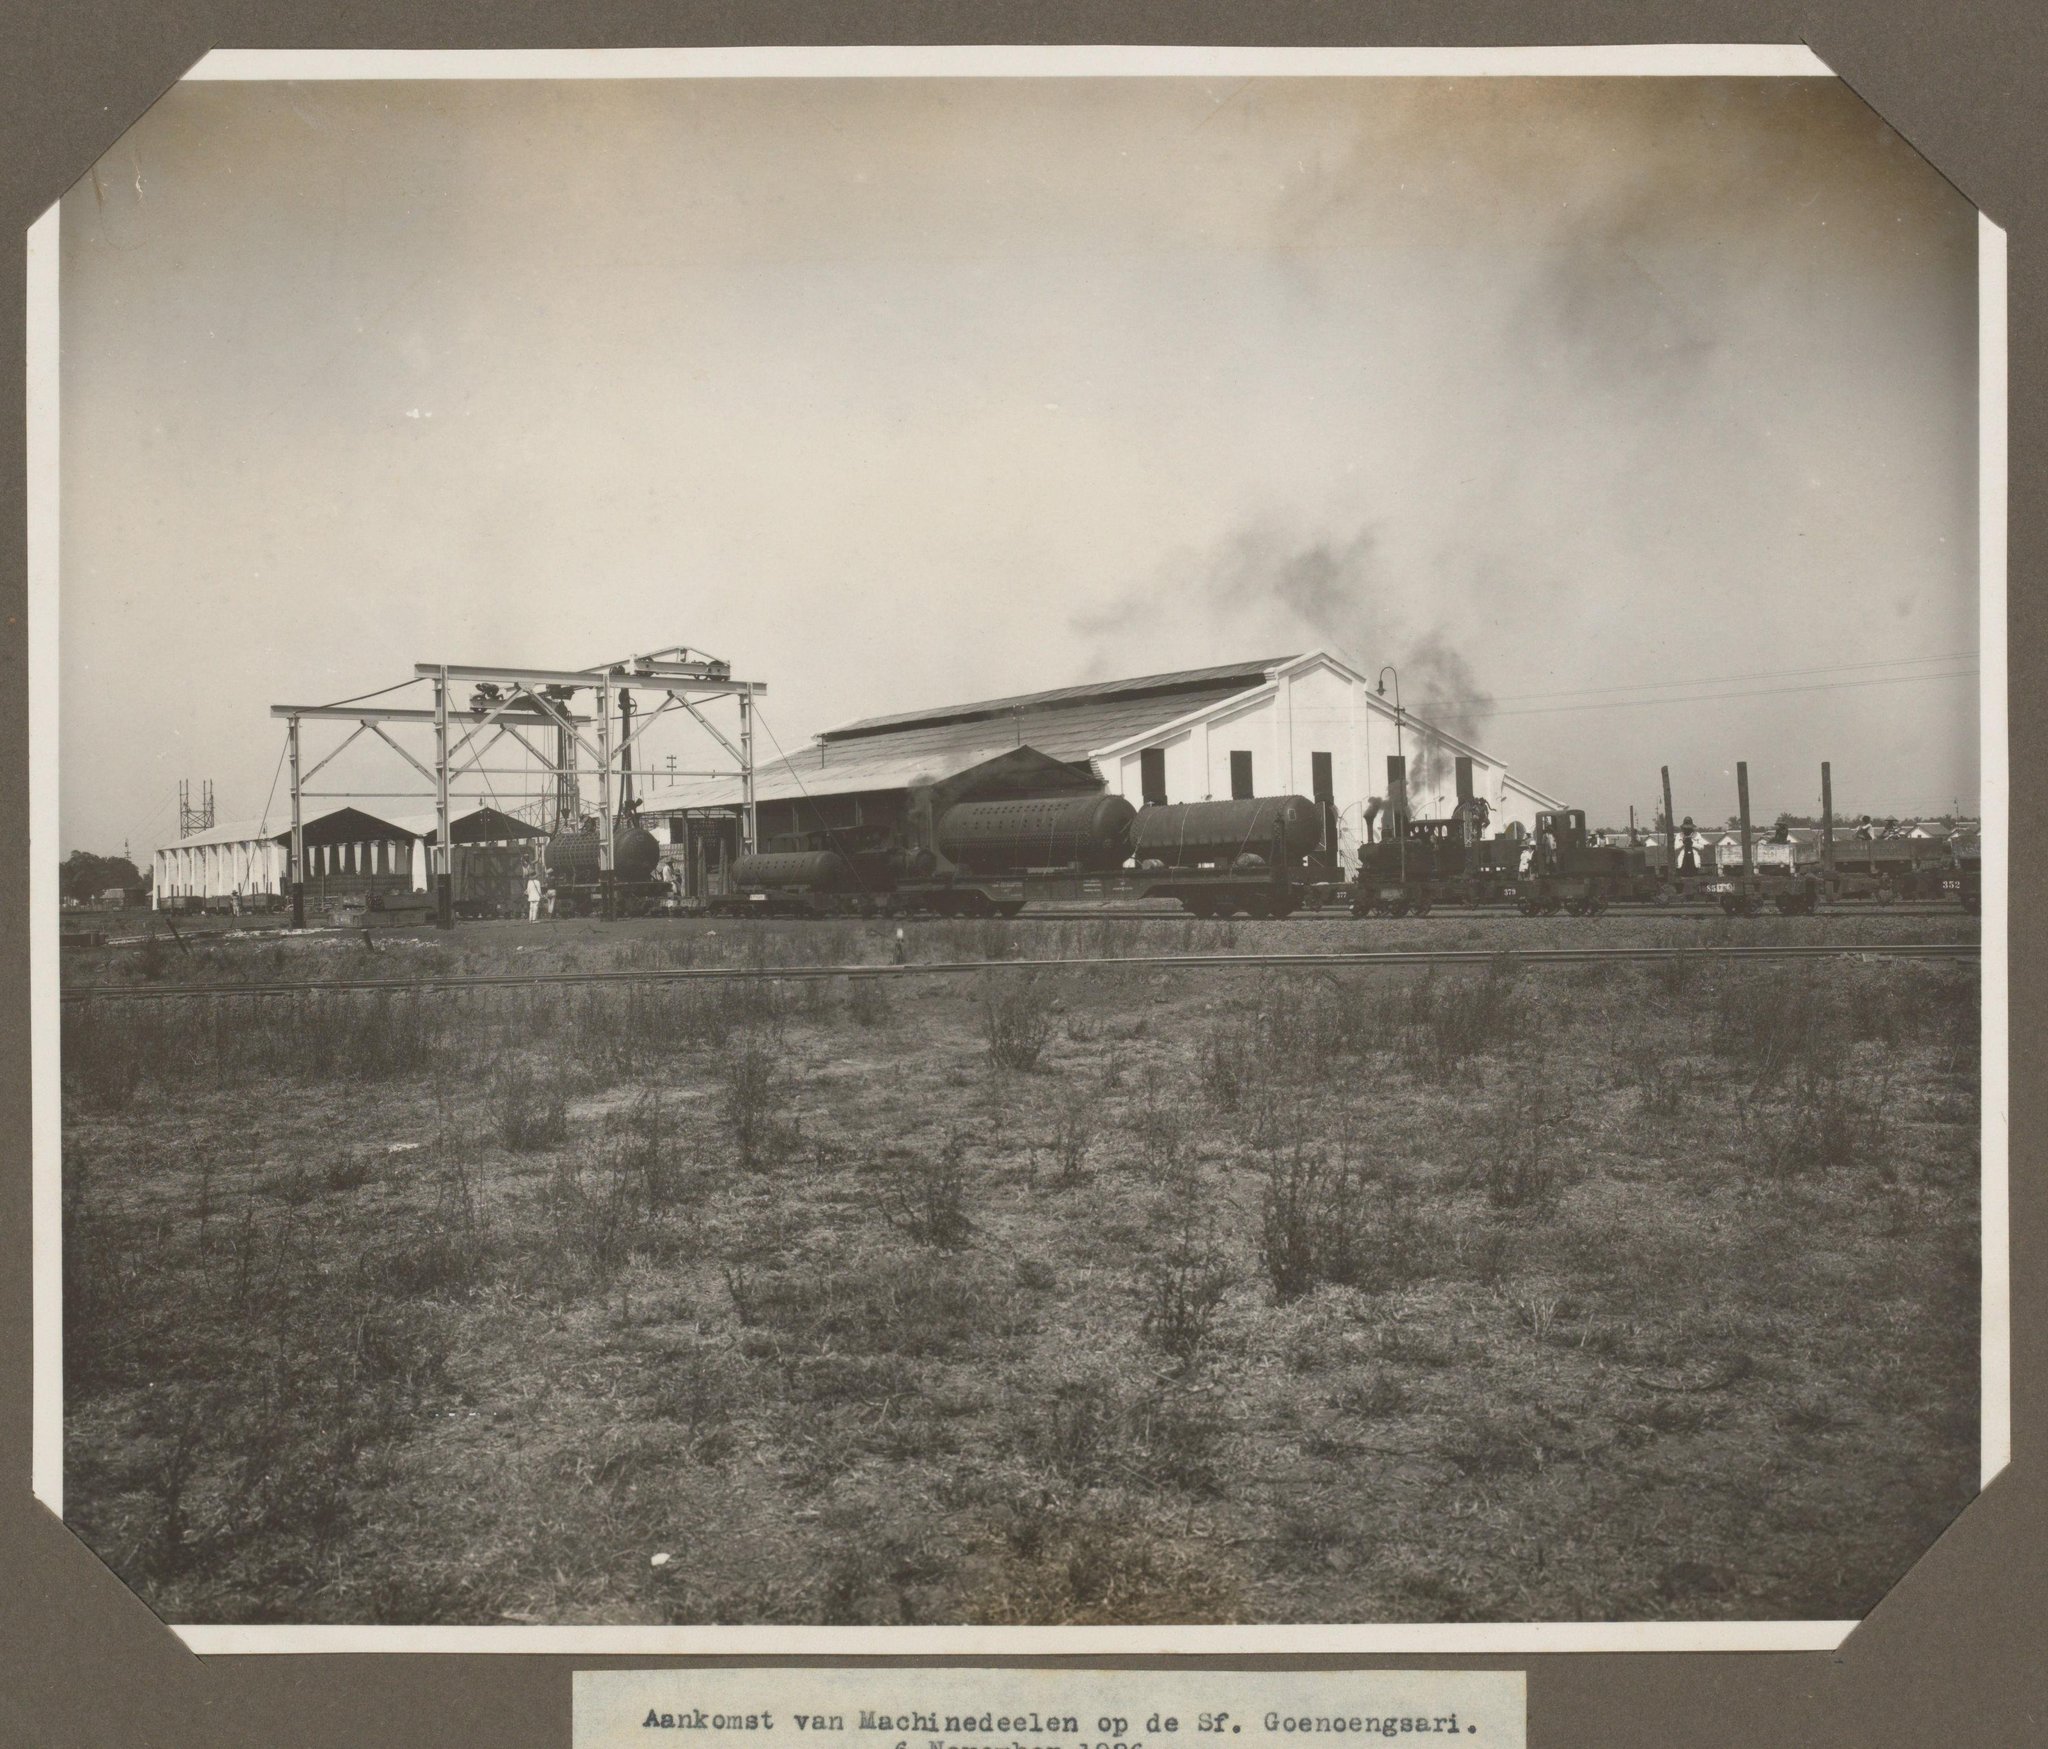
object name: photograph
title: Aankomst van Machinedeelen op de Sf. Goenoengsari. 6 November 1926.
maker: Anonymous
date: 1911-1926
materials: photographic support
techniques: gelatin silver print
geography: east java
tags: colonial system, trade-company, making the overground structures (~ building activities), (non-fruit) products of plants or trees: sugarcane, exterior of industrial structures, factories, representation of real building (either existing or having existed)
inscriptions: inscription: ‘Aankomst van Machinedeelen op de Sf. Goenoengsari. 6 November 1926.’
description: Aankomst van een trein met machineonderdelen voor de fabriek, 6 november 1926. Onderdeel van het fotoalbum met foto's van de opbouw van de suikerfabriek te Goenoengsari op Oost-Java door de Handels Vereniging Amsterdam 1926-1927.